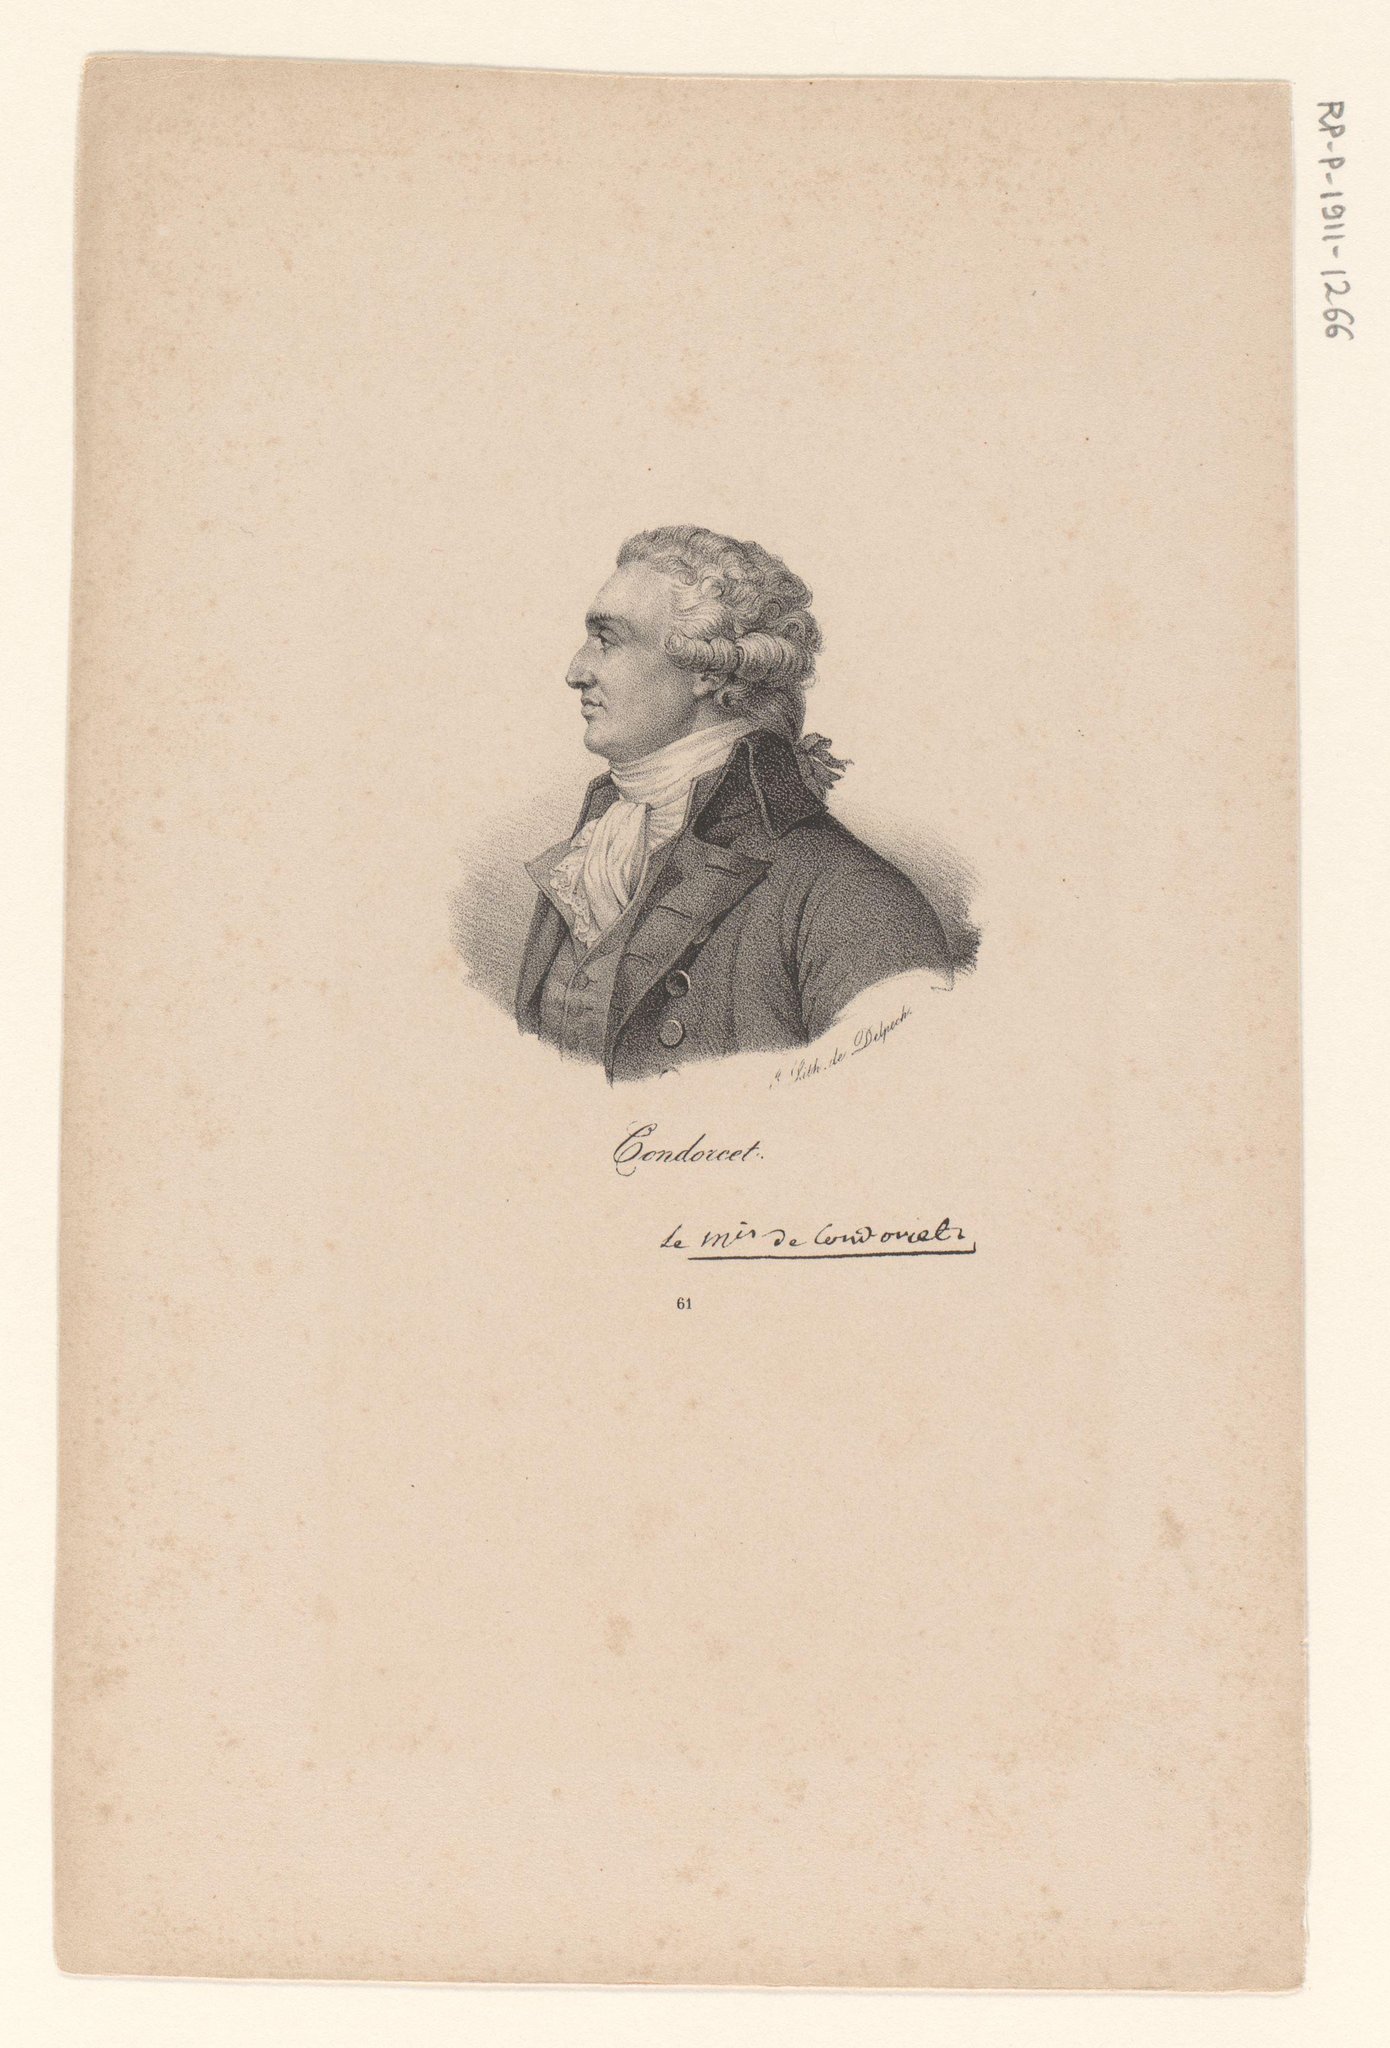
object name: print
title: Condorcet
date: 1818-1842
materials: paper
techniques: lithograph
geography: paris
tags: historical persons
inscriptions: collector's mark: Lugt 2228a